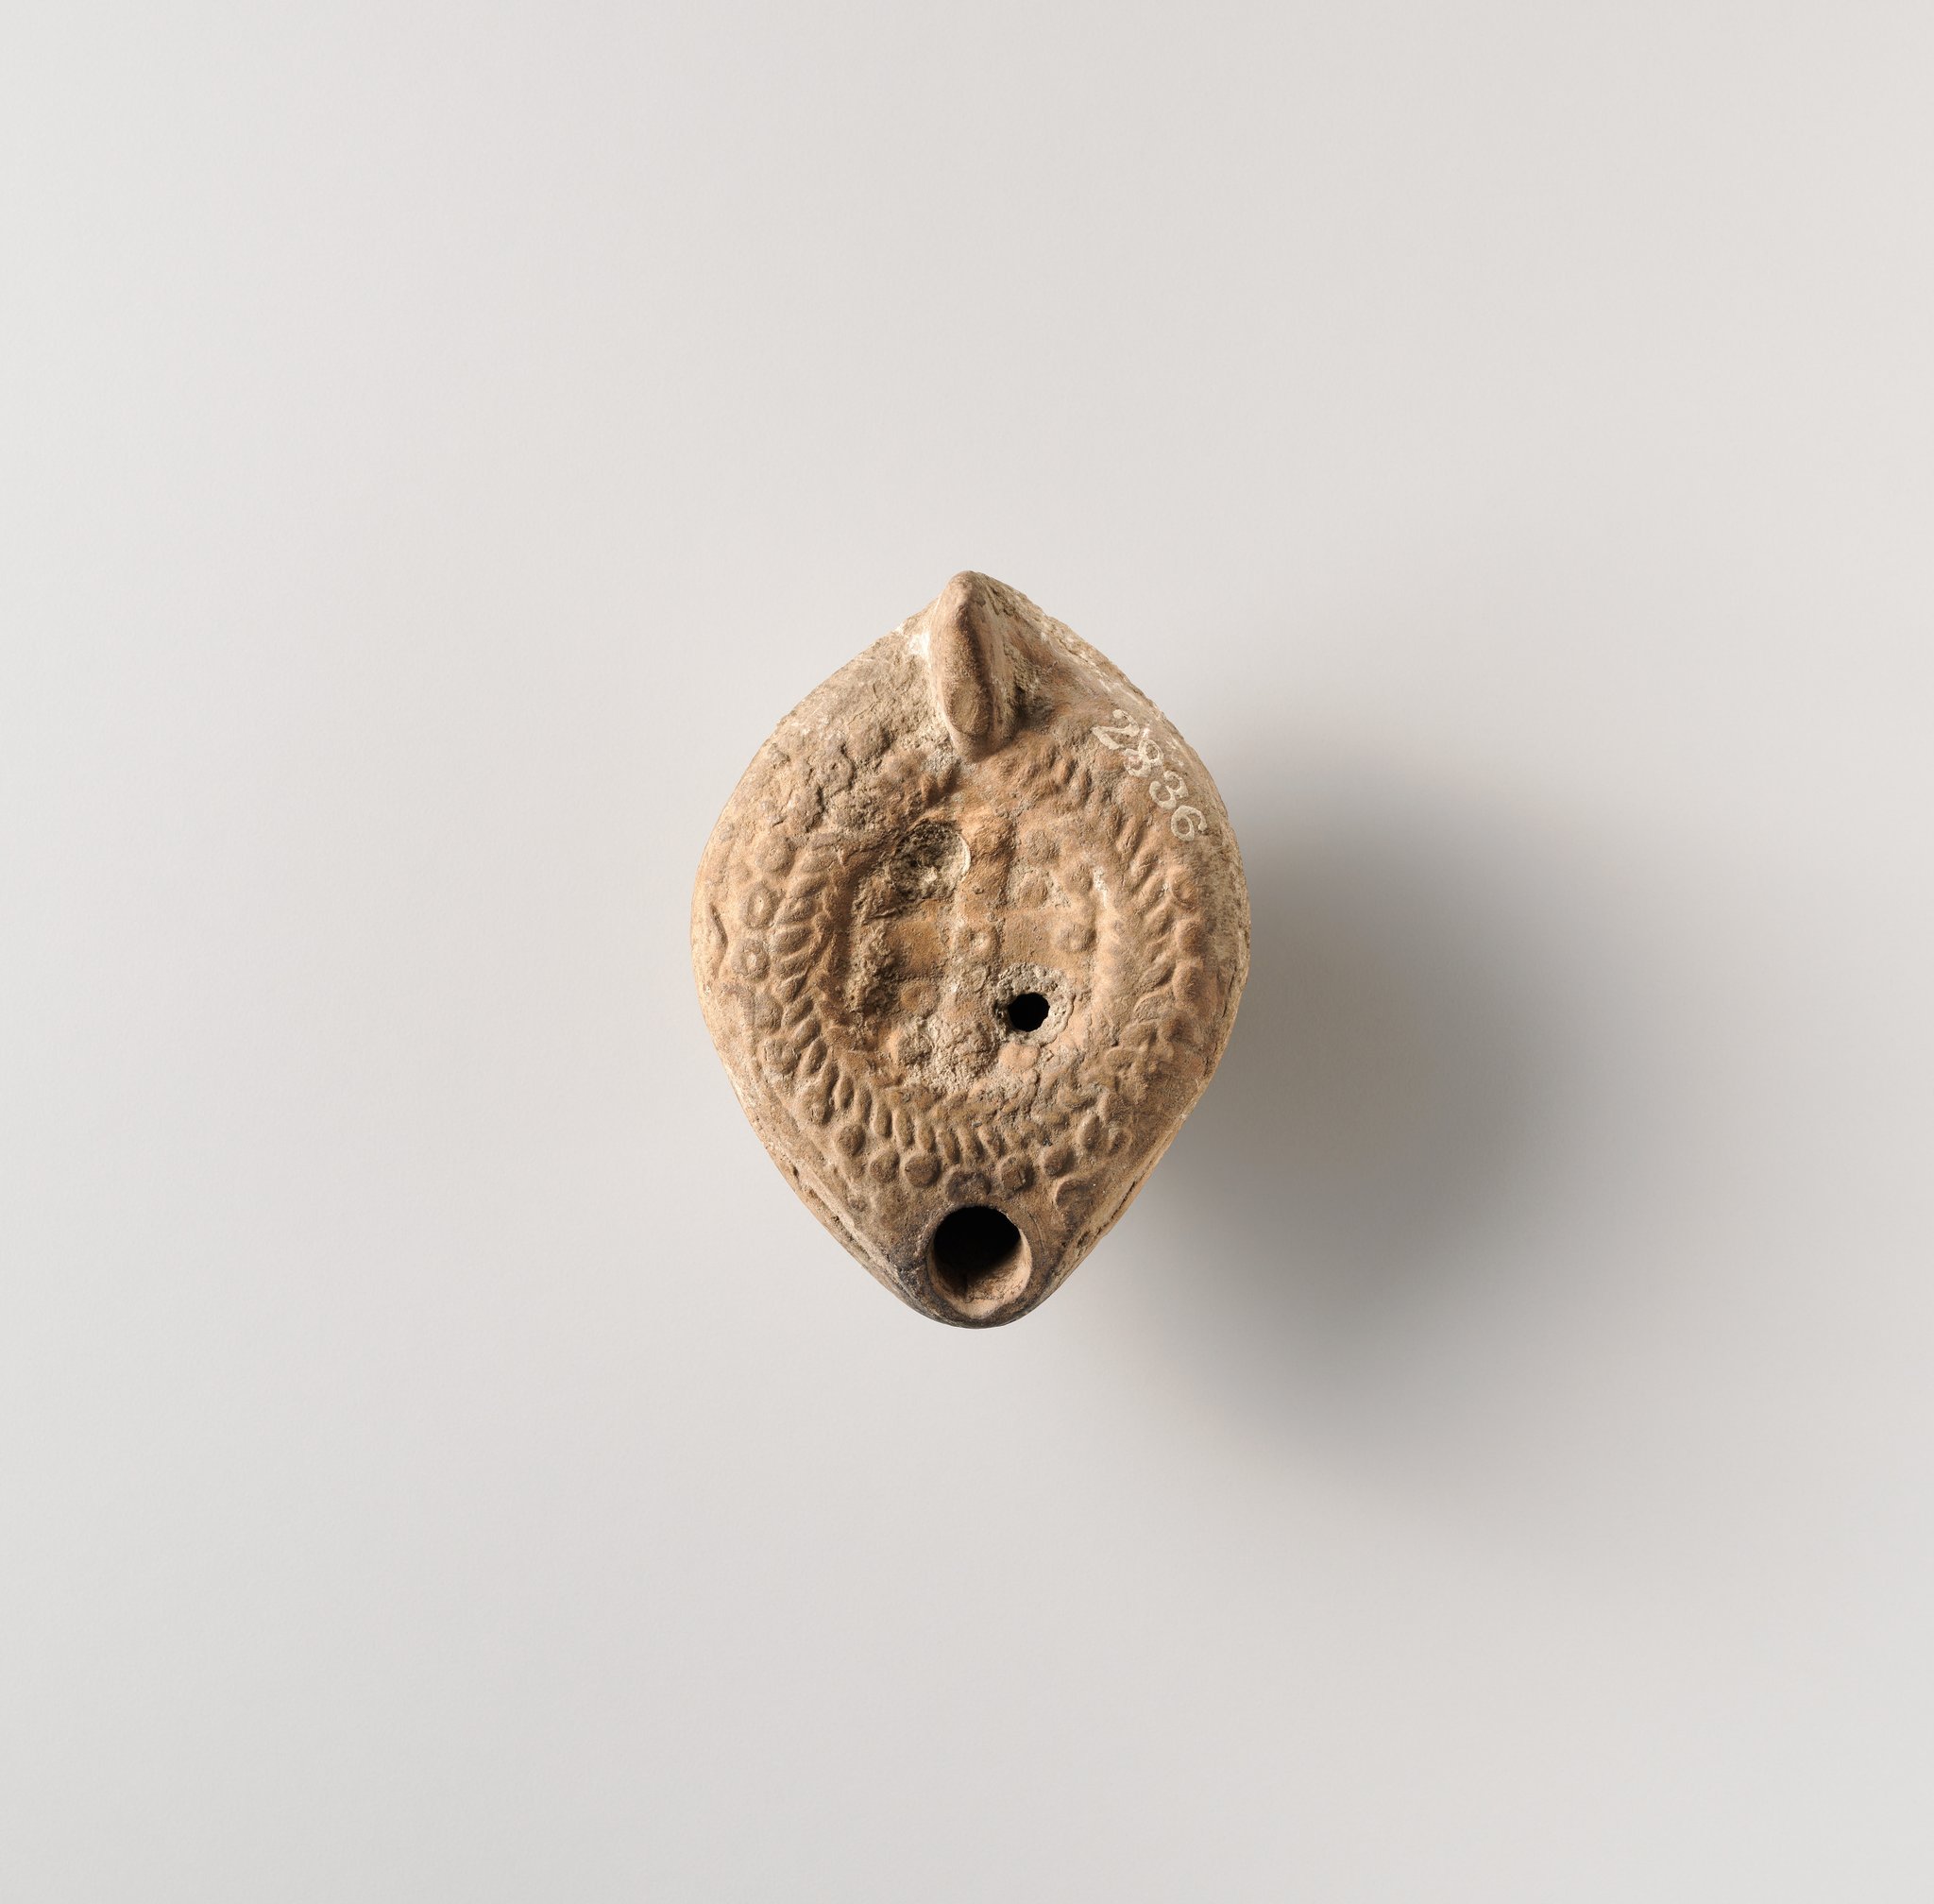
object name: lamp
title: Terracotta oil lamp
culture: roman, cypriot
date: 401-500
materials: terracotta